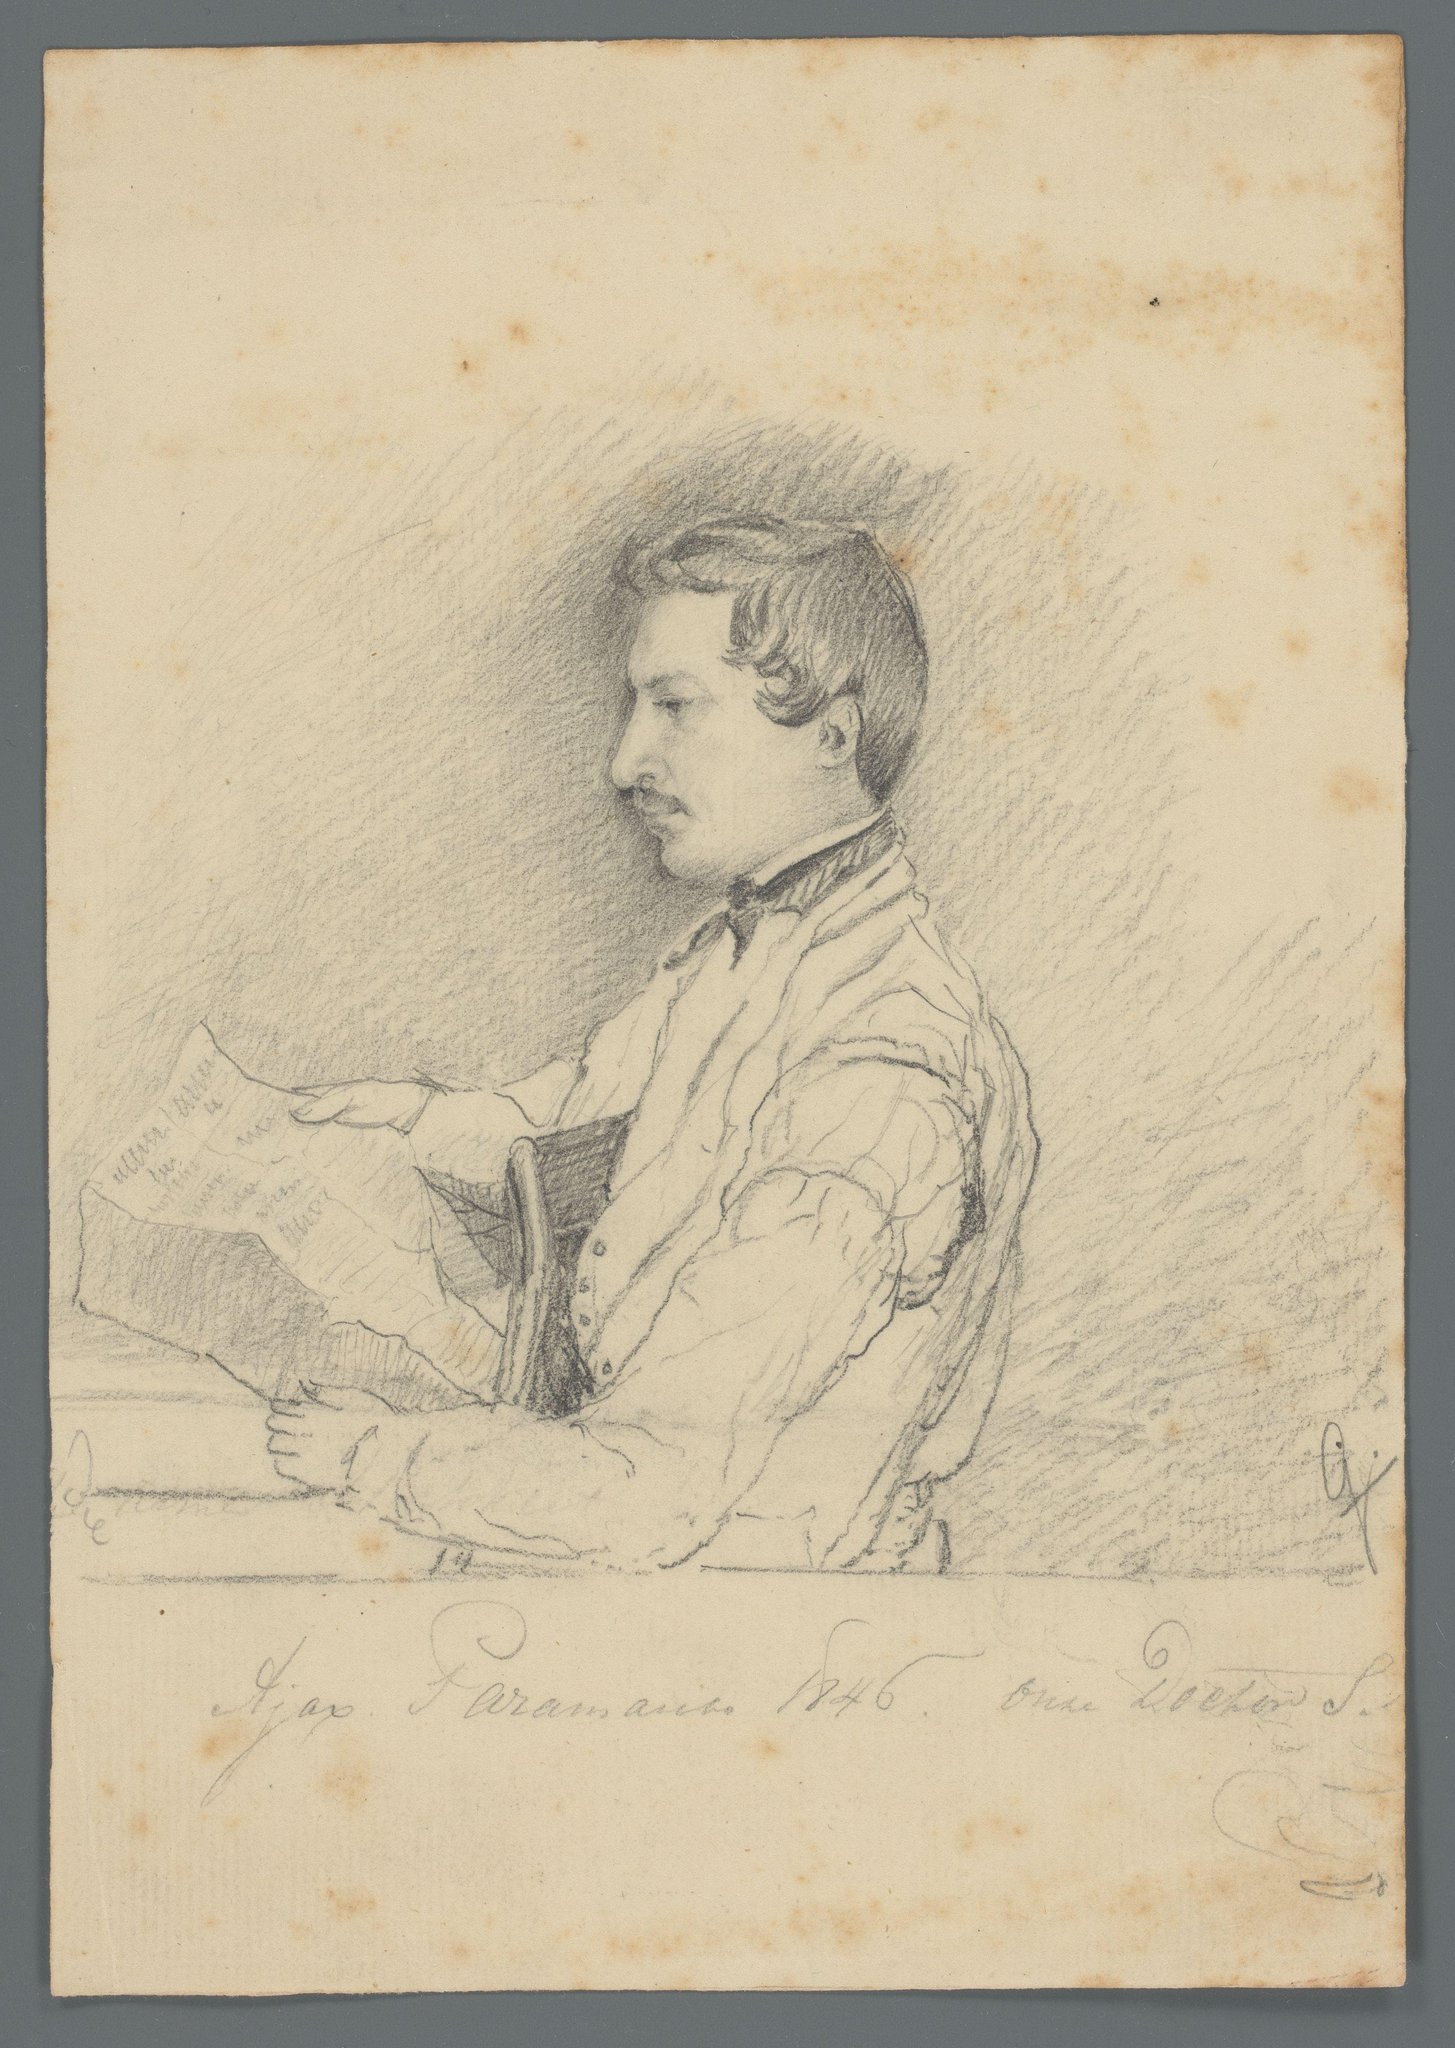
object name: drawing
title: Portret van een man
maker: frederik lambertus geerling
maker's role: naval officer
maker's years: 1815-1894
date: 1846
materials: paper, pencil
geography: paramaribo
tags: reading, newspaper, news-sheet, historical persons not known by name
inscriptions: inscription: ‘Ajax Paramaribo 1846 onze Doctor S.’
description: Portret van een man, volgens het onderschrift 'onze Doctor', een krant lezend. Getekend aan boord van het schip 'Ajax', in 1846 gelegen in Paramaribo.